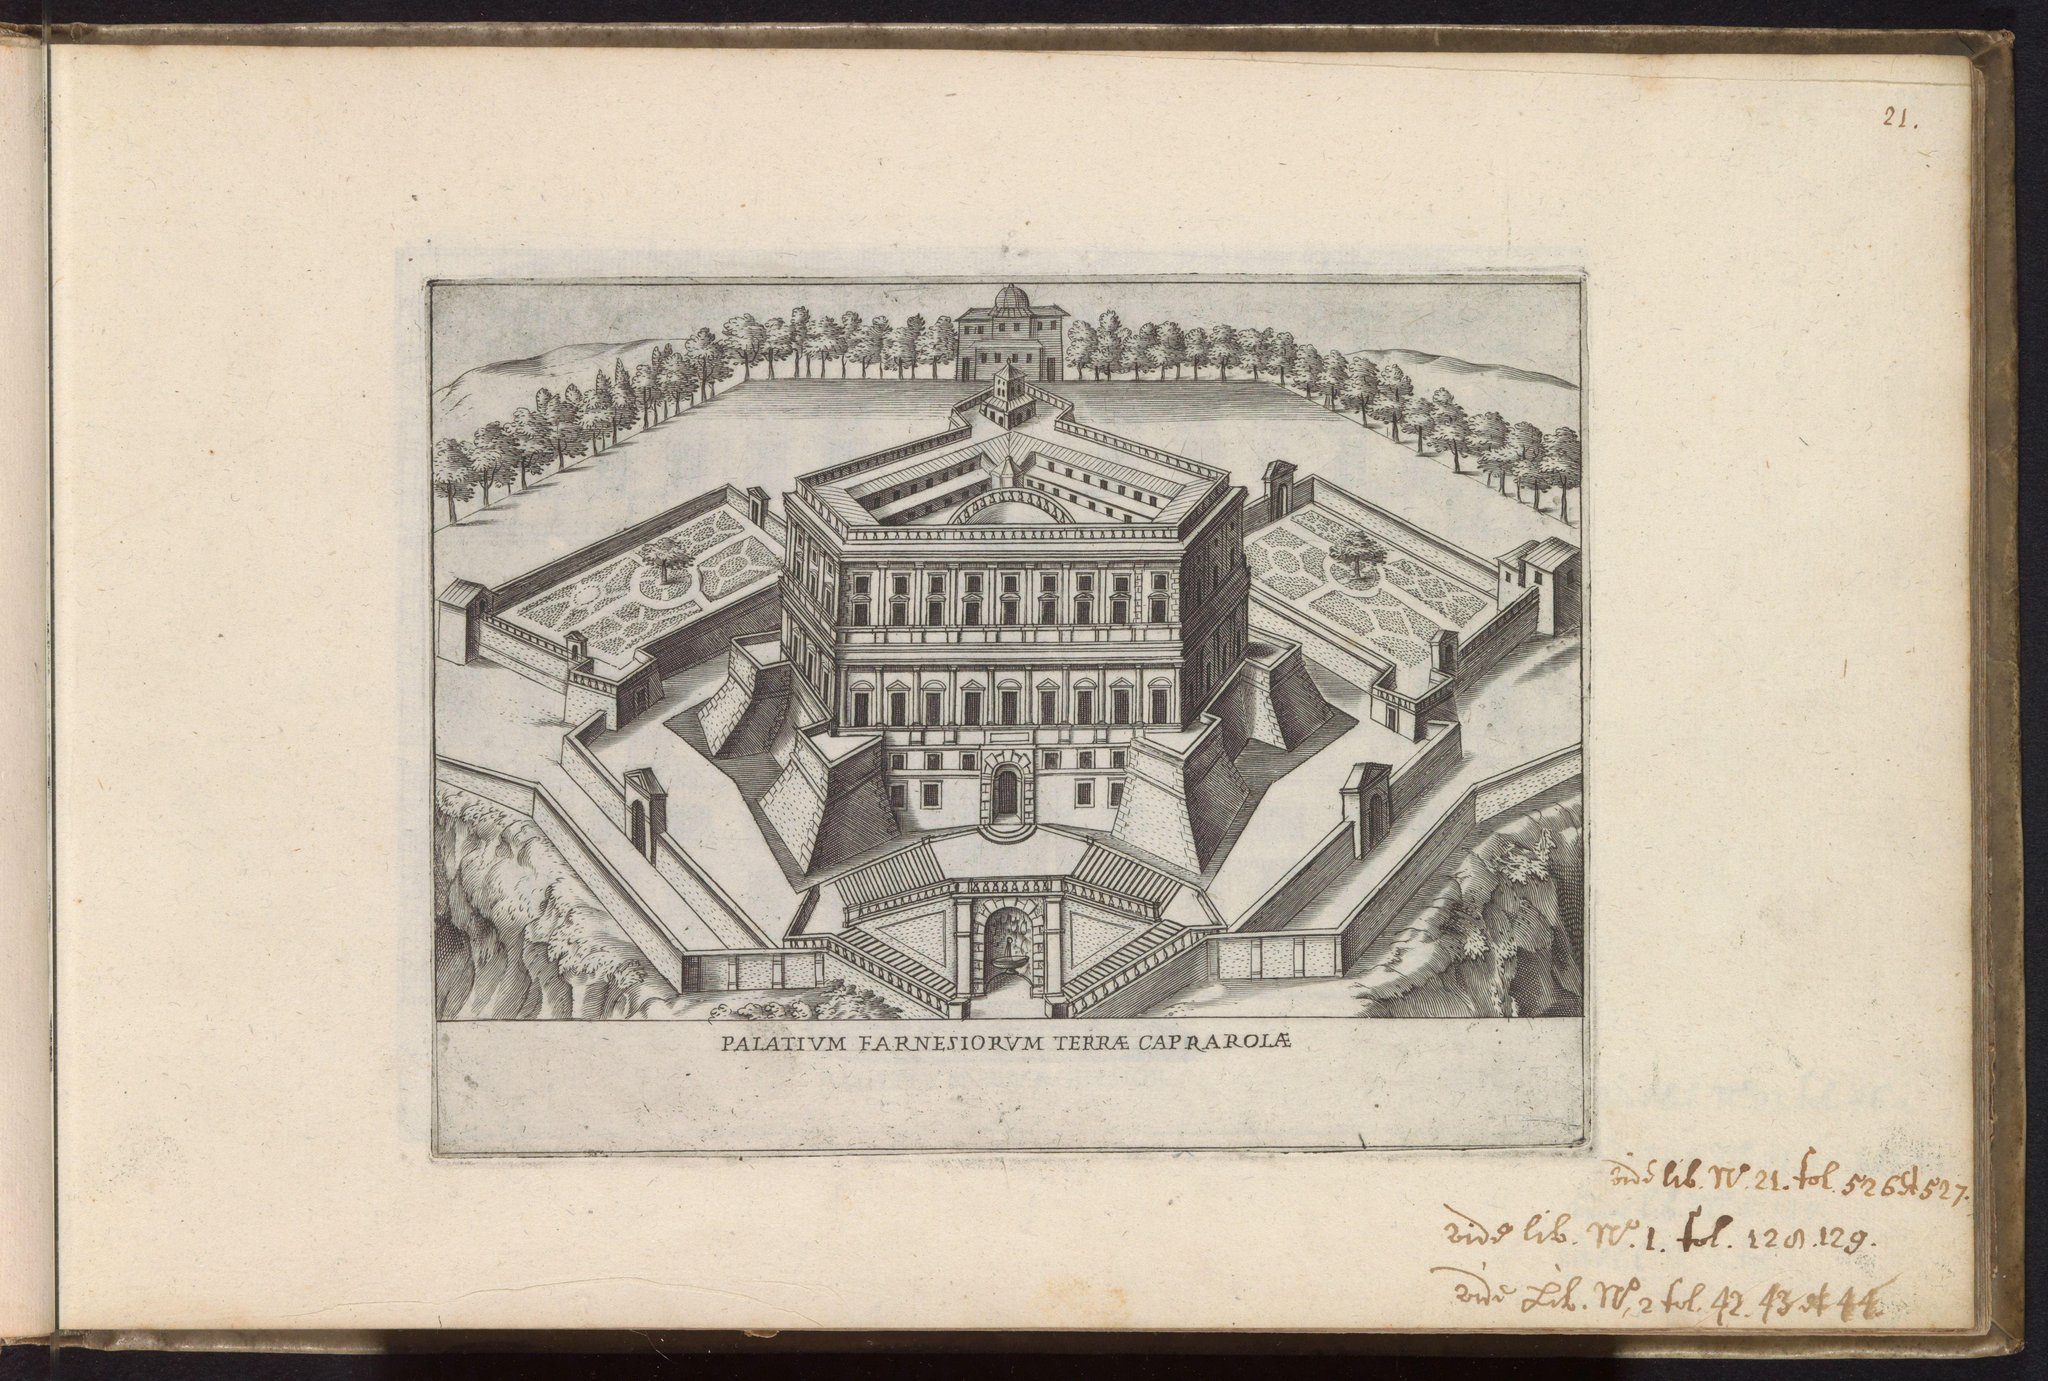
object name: album leaf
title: Palazzi diversi nel'alma cità di Roma, et altre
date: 1638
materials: paper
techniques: etching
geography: rome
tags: villa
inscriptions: number: ‘21’, inscription: ‘Ende lib. No. 21. fol. 526 et 527/ Ende lib. No. 1. fol. 128. 129./ Ende lib. No. 2 fol. 42. 43 et 44.’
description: Prent maakt deel uit van een reeks prenten (+ titelprent) van beroemde gebouwen in Rome en elders.